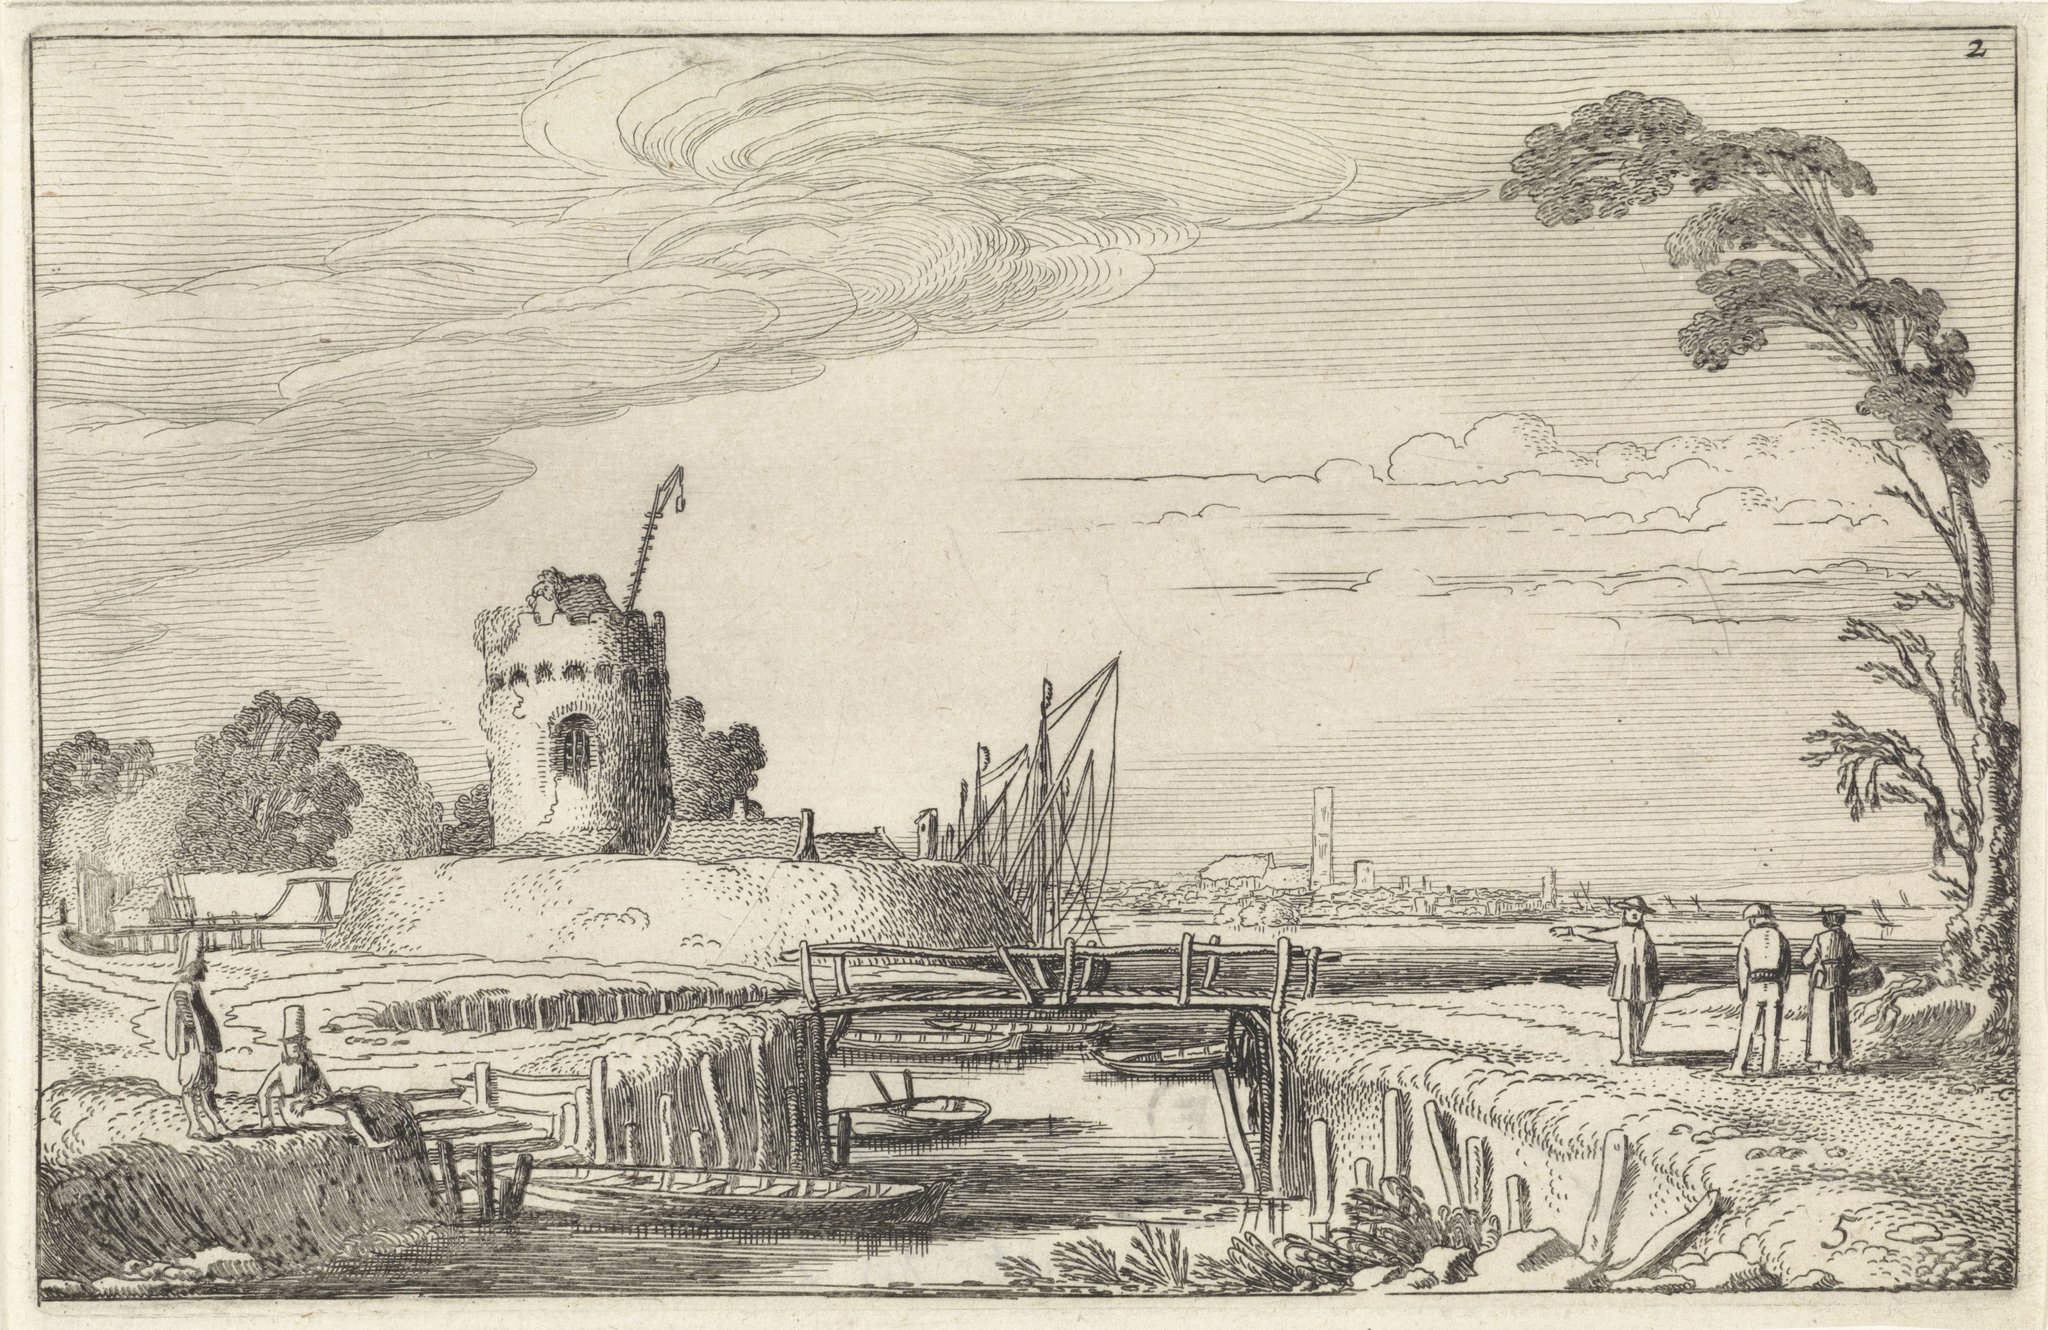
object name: print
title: Landschappen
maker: jan van de velde (ii)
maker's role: draughtsman, painter, print maker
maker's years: 1593-1641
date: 1616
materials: paper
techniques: etching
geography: northern netherlands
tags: harbour, lighthouse, lightship, bridges by construction, landscape with tower or castle, pier, quay, wharf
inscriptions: collector's mark: Lugt 964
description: Figuren bij een haven bij een toren, die als vuurtoren wordt gebruikt. Tussen de kades een houten brug. Aan de horizon een stad. Vijfde prent van deel twee van een serie van in totaal zestig prenten met landschappen, verdeeld over vijf delen van elk twaalf prenten.